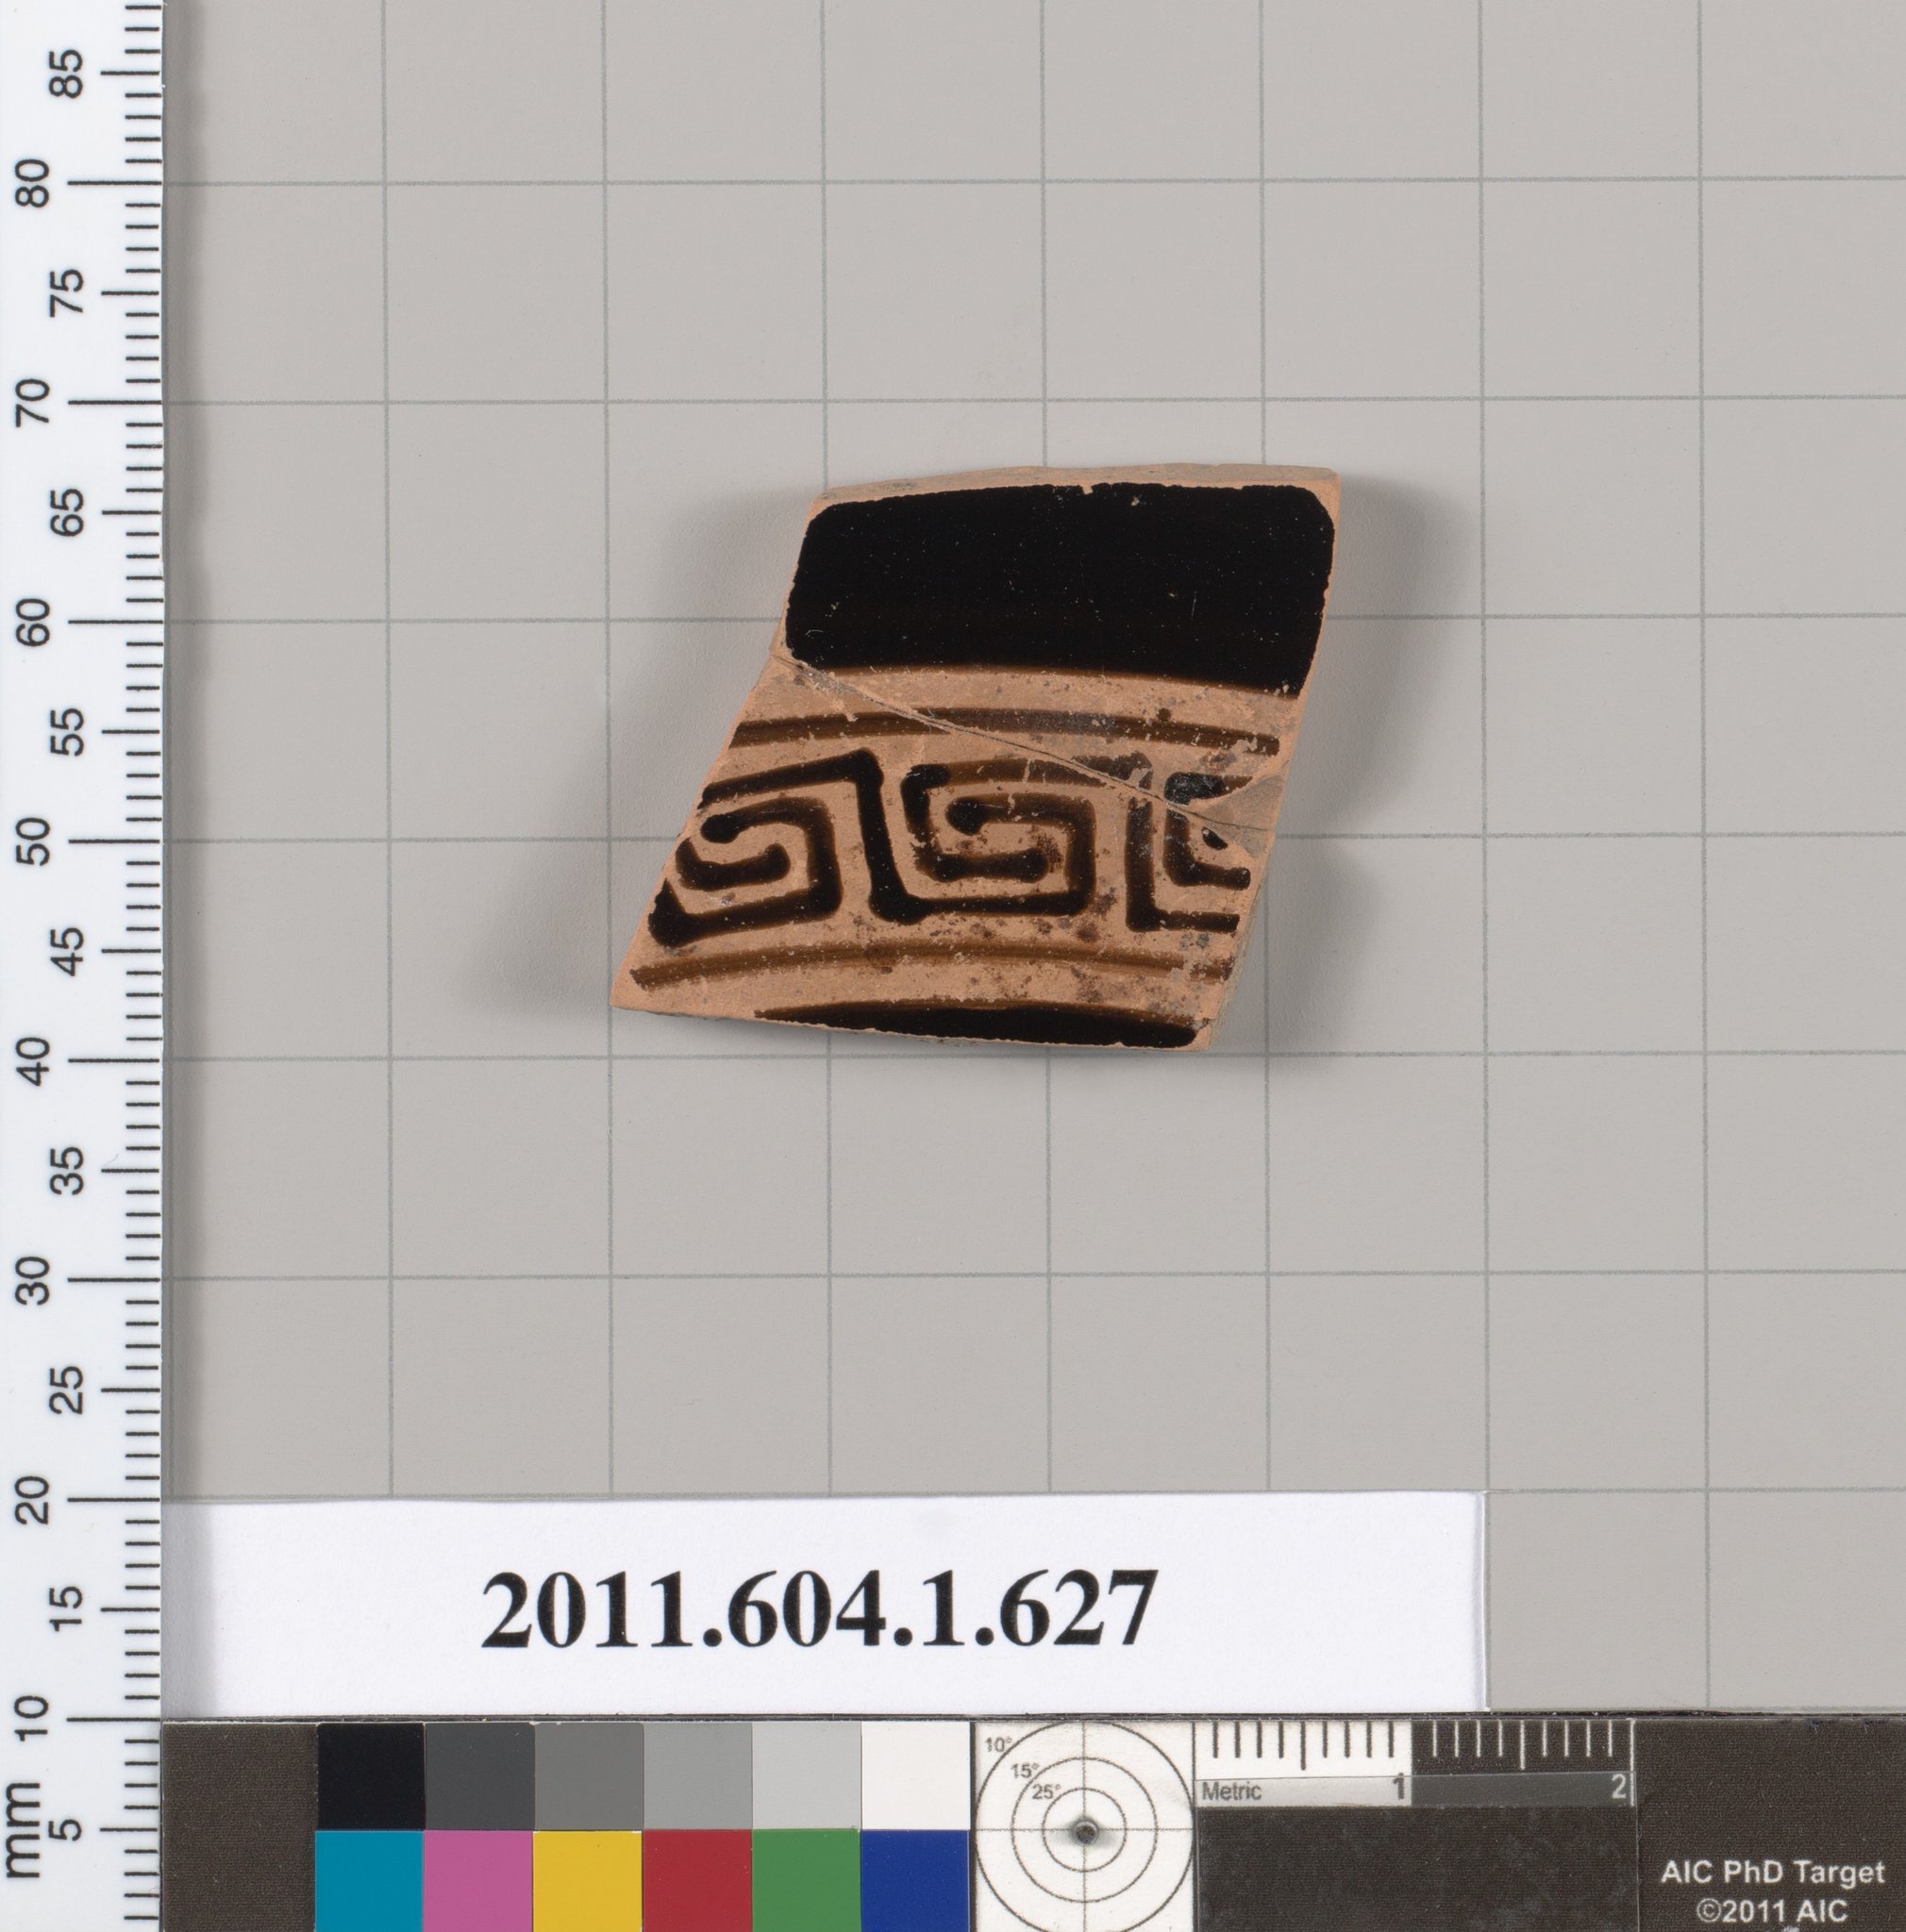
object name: kylix fragment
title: Terracotta fragment of a kylix (drinking cup)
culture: greek, attic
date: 475-451 BCE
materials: terracotta